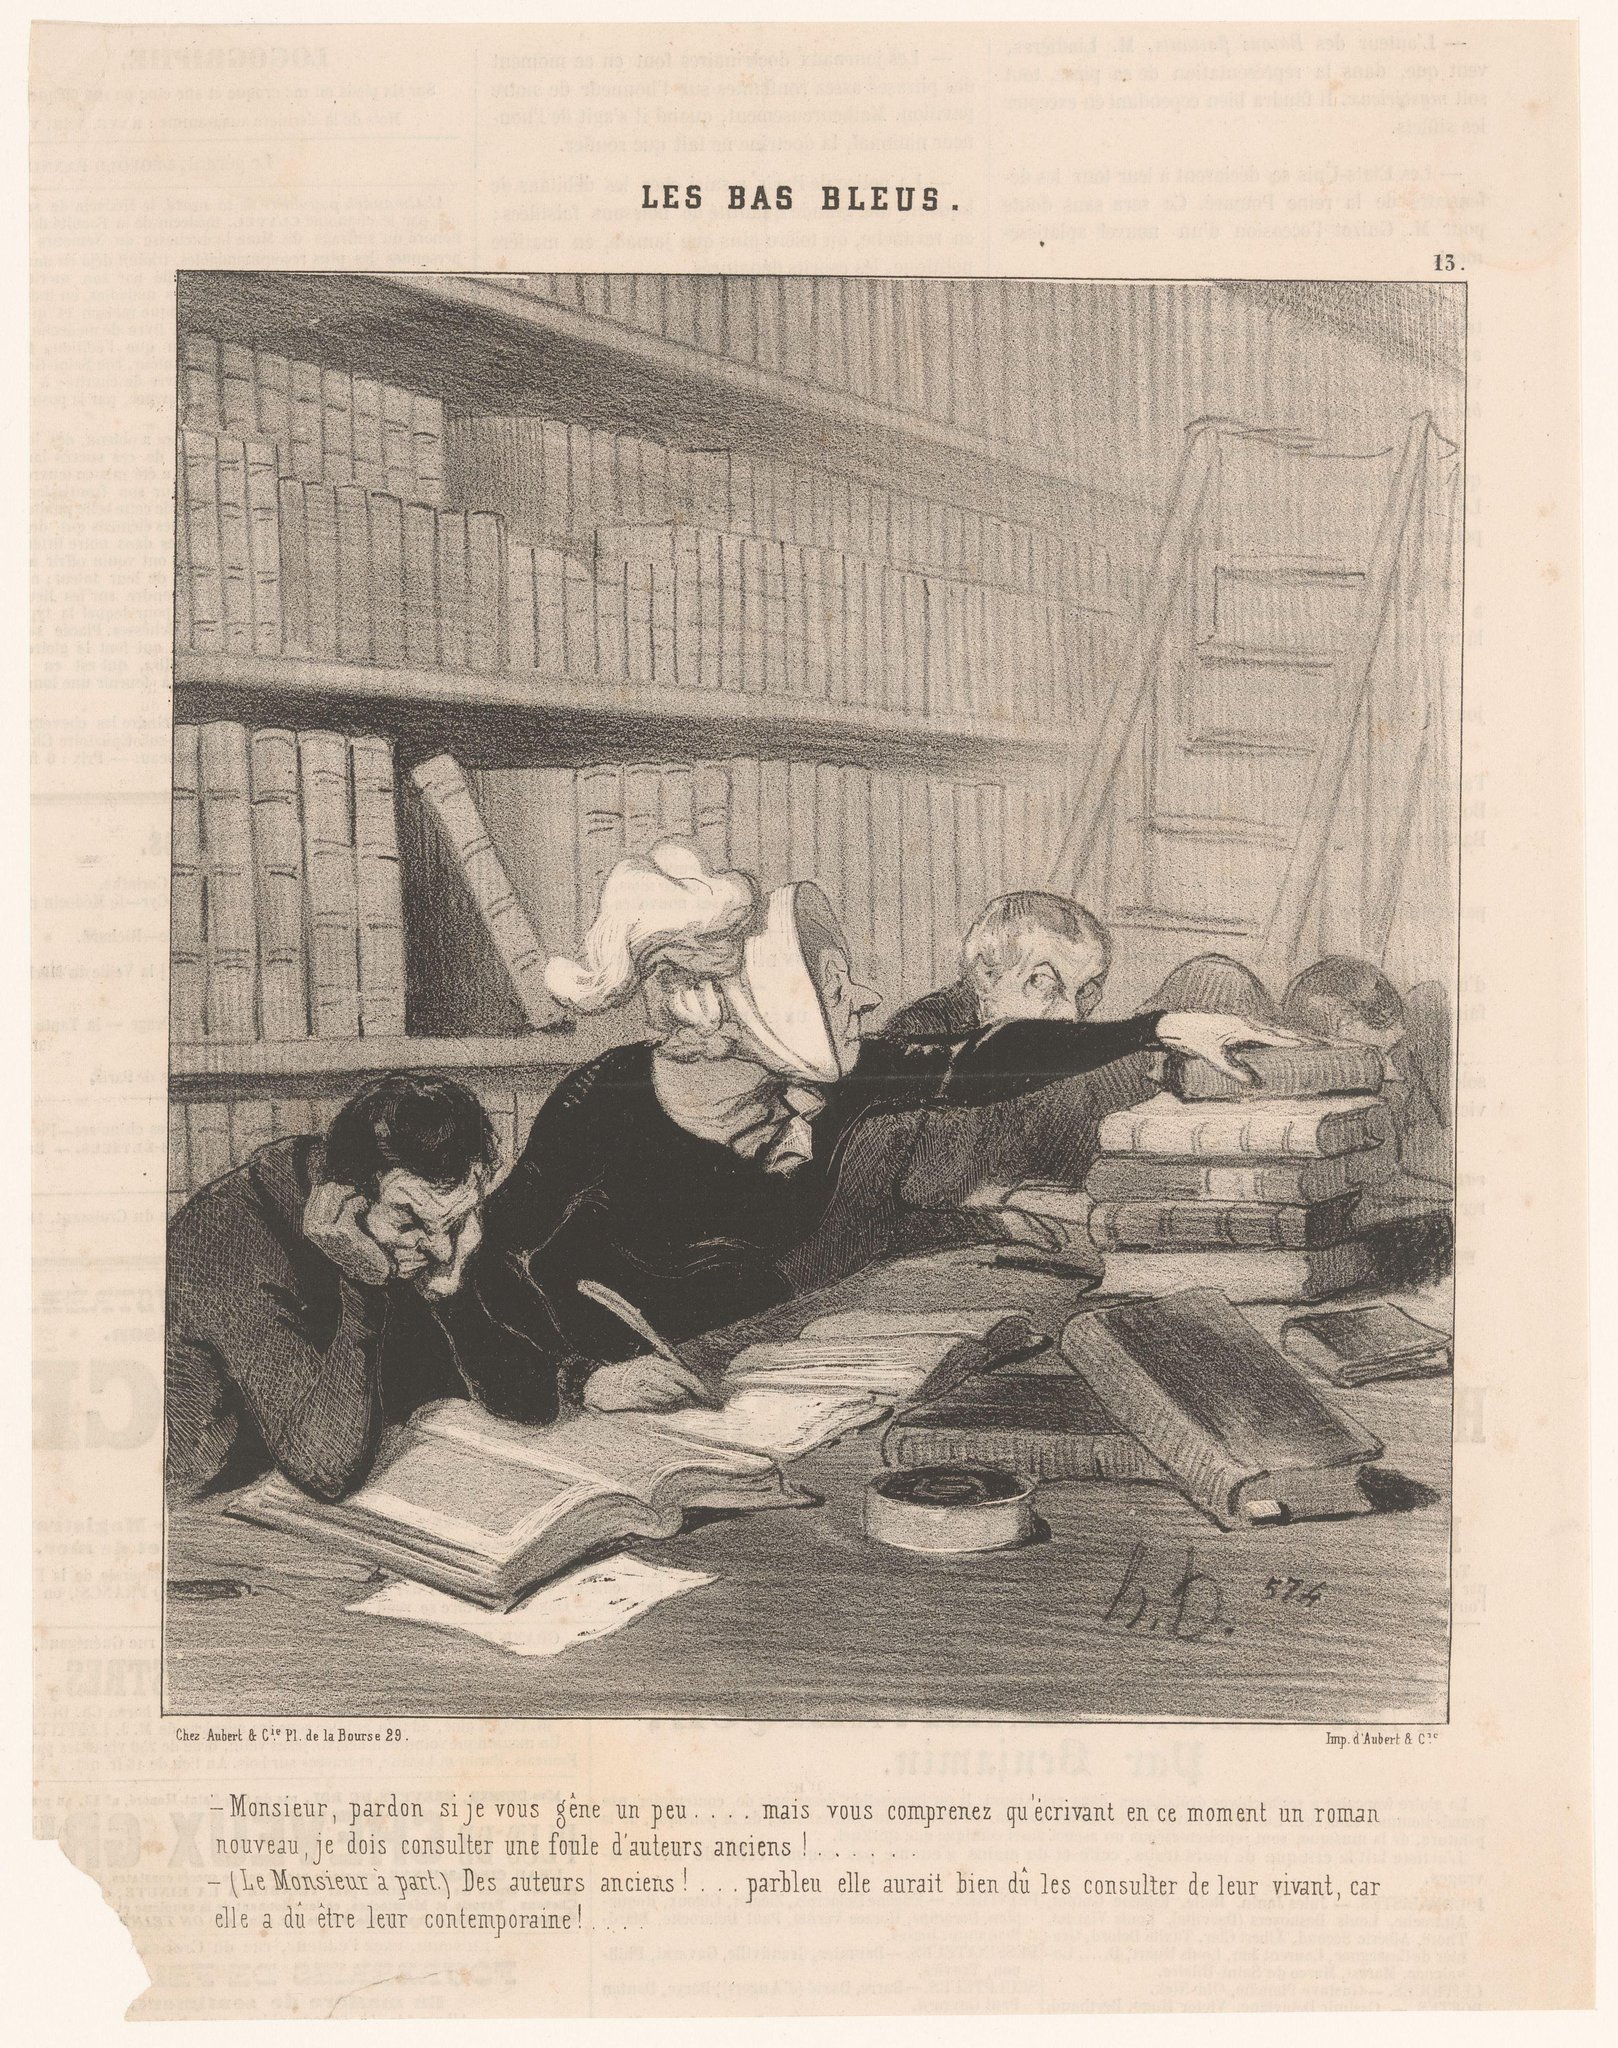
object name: cartoon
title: Monsieur, pardon, si je vous gêne un peu (...)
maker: honoré daumier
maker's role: draughtsman, painter, print maker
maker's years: 1808-1879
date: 1844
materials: paper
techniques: lithograph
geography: paris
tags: caricatures (human types), writer, poet, author, public library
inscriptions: collector's mark: Lugt 2228a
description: De vrouw moet naar eigen zeggen oude auteurs raadplegen voor haar nieuwe roman.